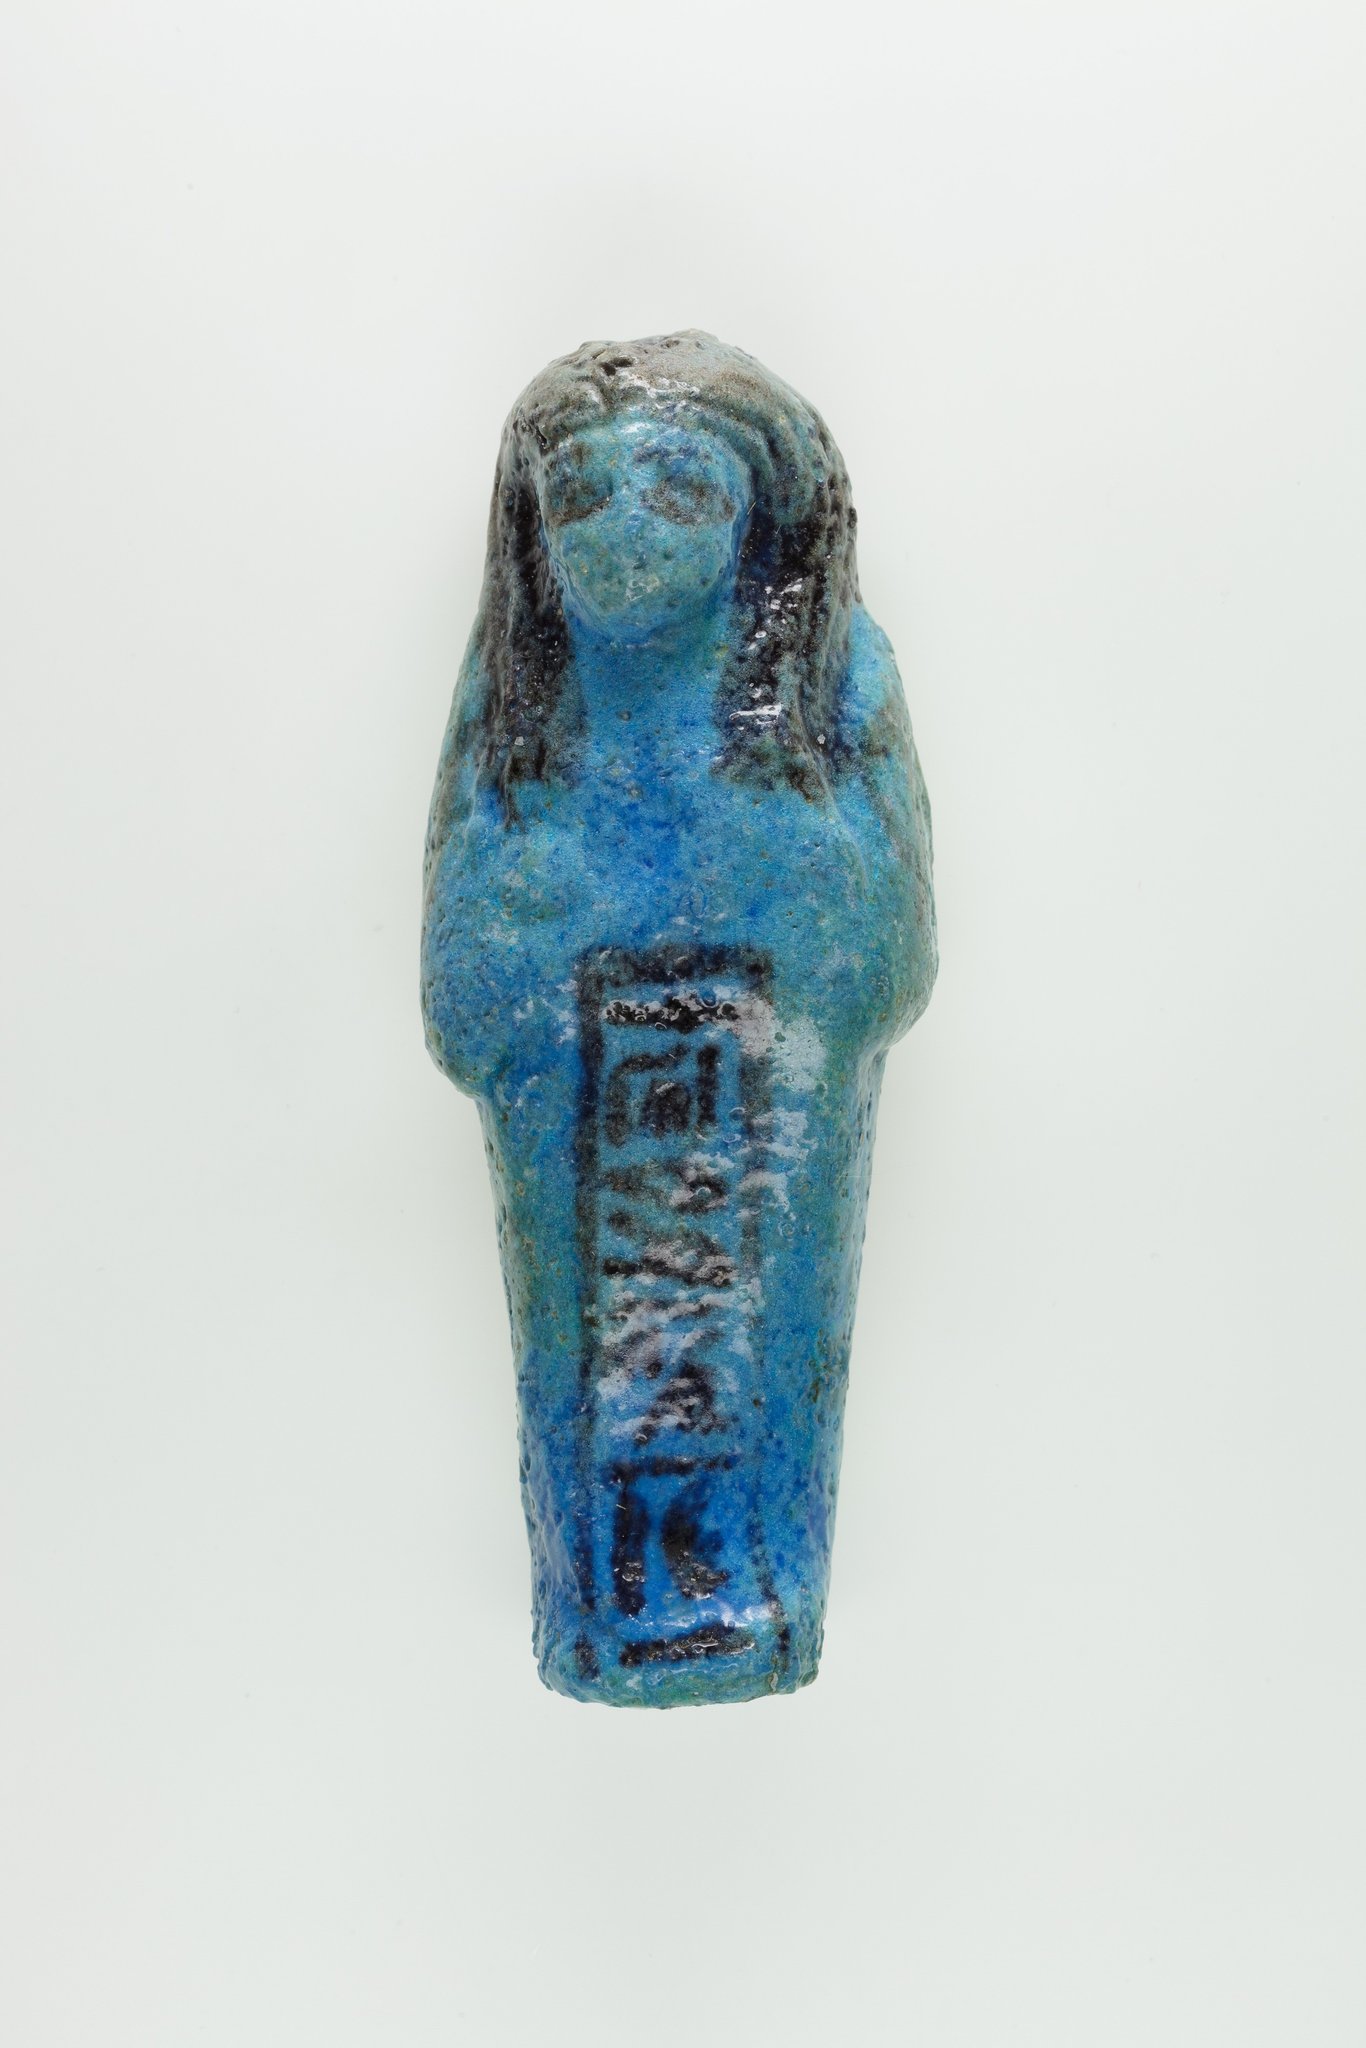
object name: shabti, worker, nauny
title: Worker Shabti of Nauny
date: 1050 BCE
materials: faience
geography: egypt